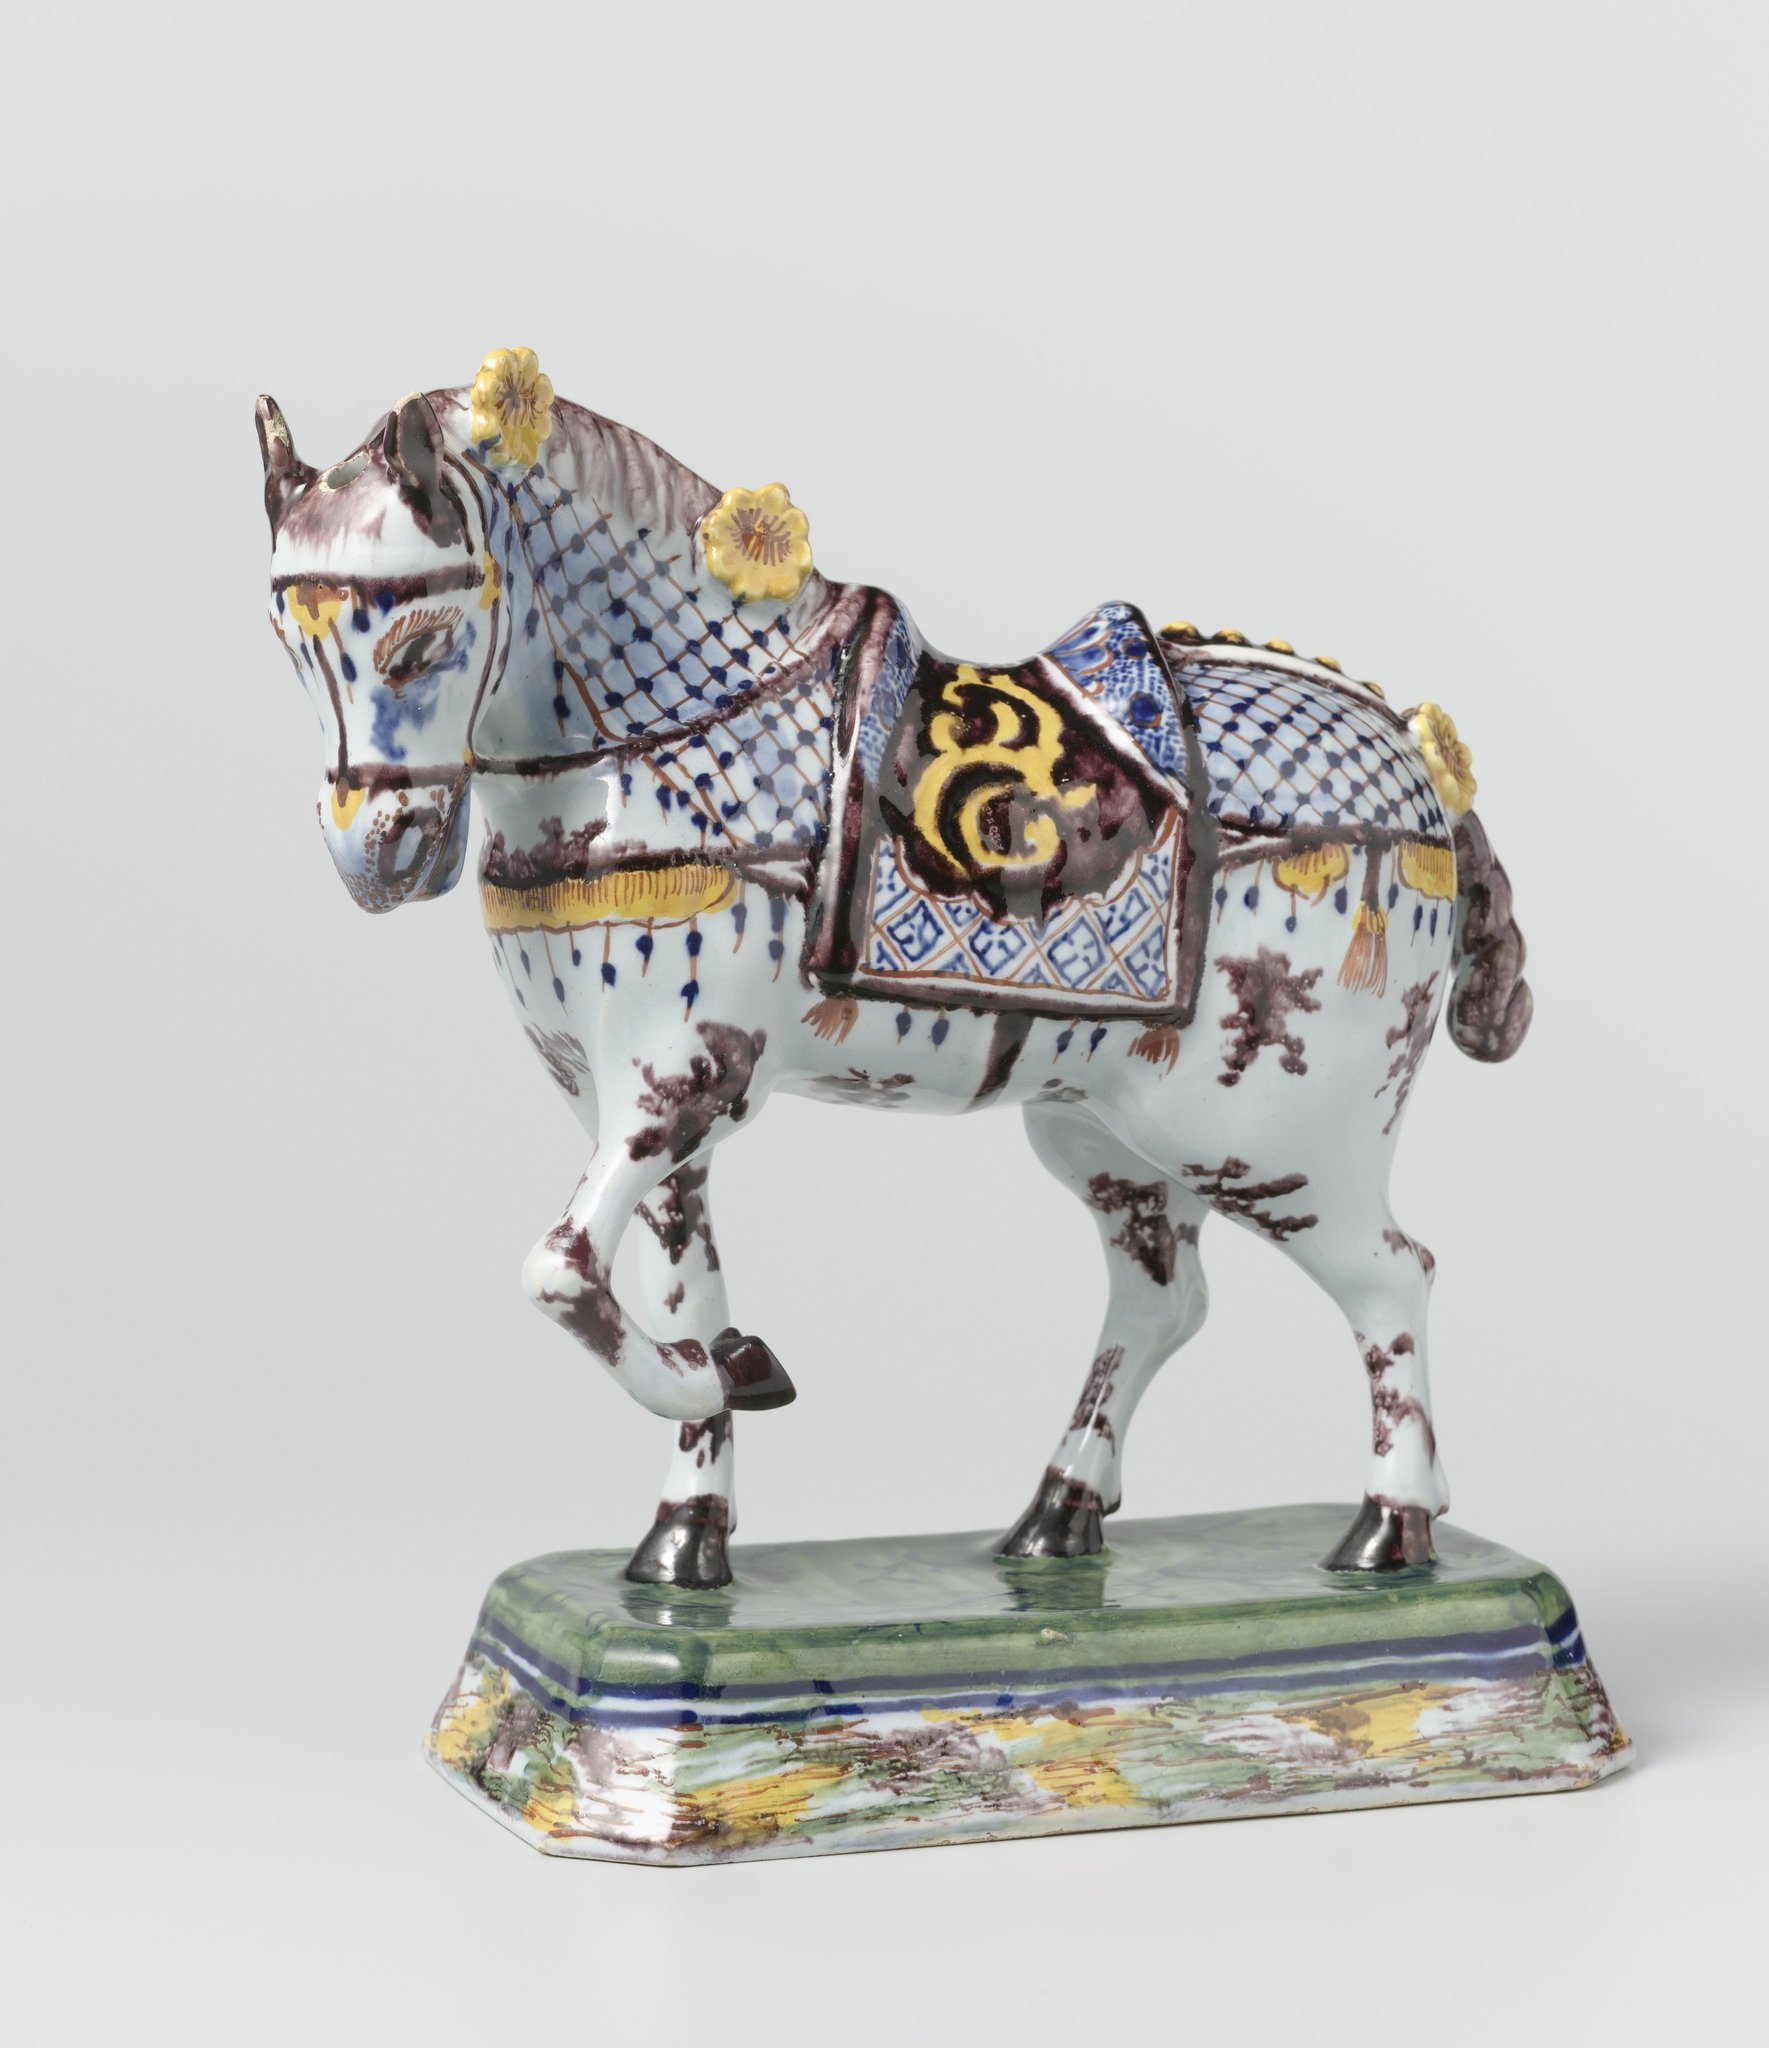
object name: dierfiguur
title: Paard van faience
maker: johannes van duijn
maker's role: plateelbakker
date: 1760-1780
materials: faience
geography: delft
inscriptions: collector's mark: ‘onleesbaar (doorgekrast)’, collector's mark: ‘R[...]H’, mark: ‘I/ VDUIJN (ineen)’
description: Dierenfiguur van faience, voorstellende een opgetuigd paard.